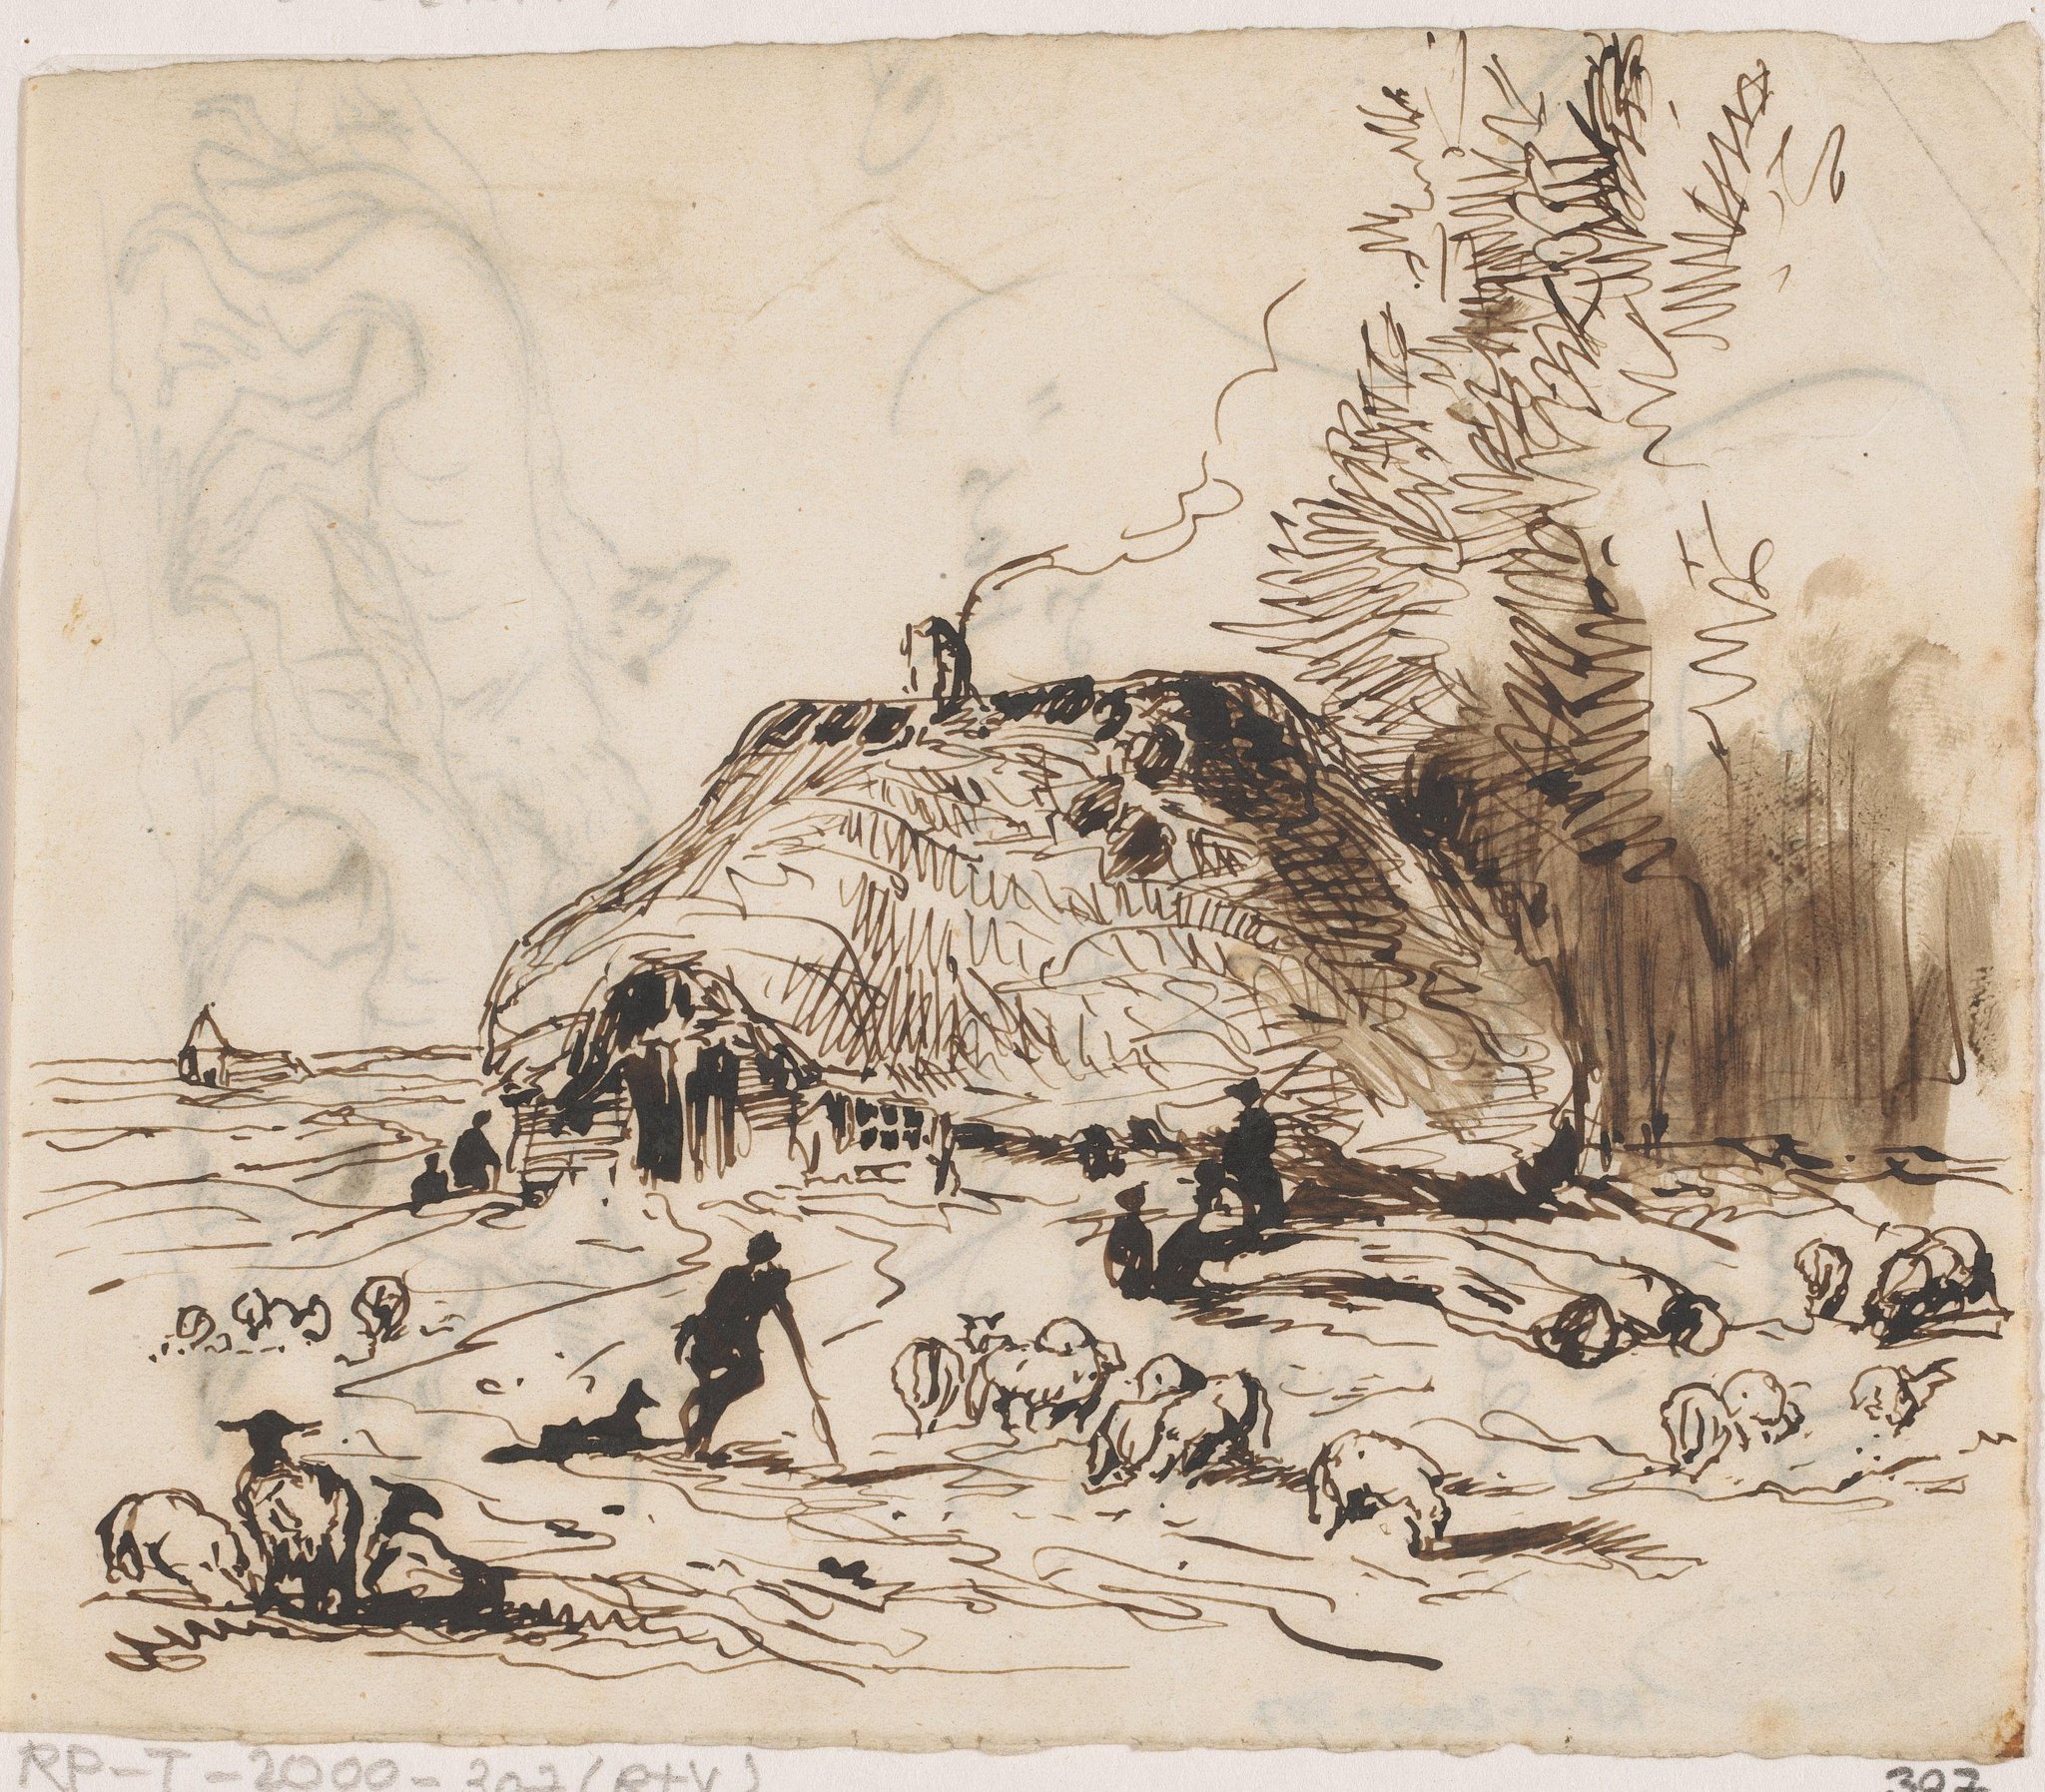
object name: drawing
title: Schaapherder voor een boerderij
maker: johannes tavenraat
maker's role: draughtsman, painter, print maker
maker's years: 1809-1881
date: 1840-1880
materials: ink, paper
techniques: brush, pen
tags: herding, herdsman, herdswoman, shepherd, shepherdess, cowherd, etc.